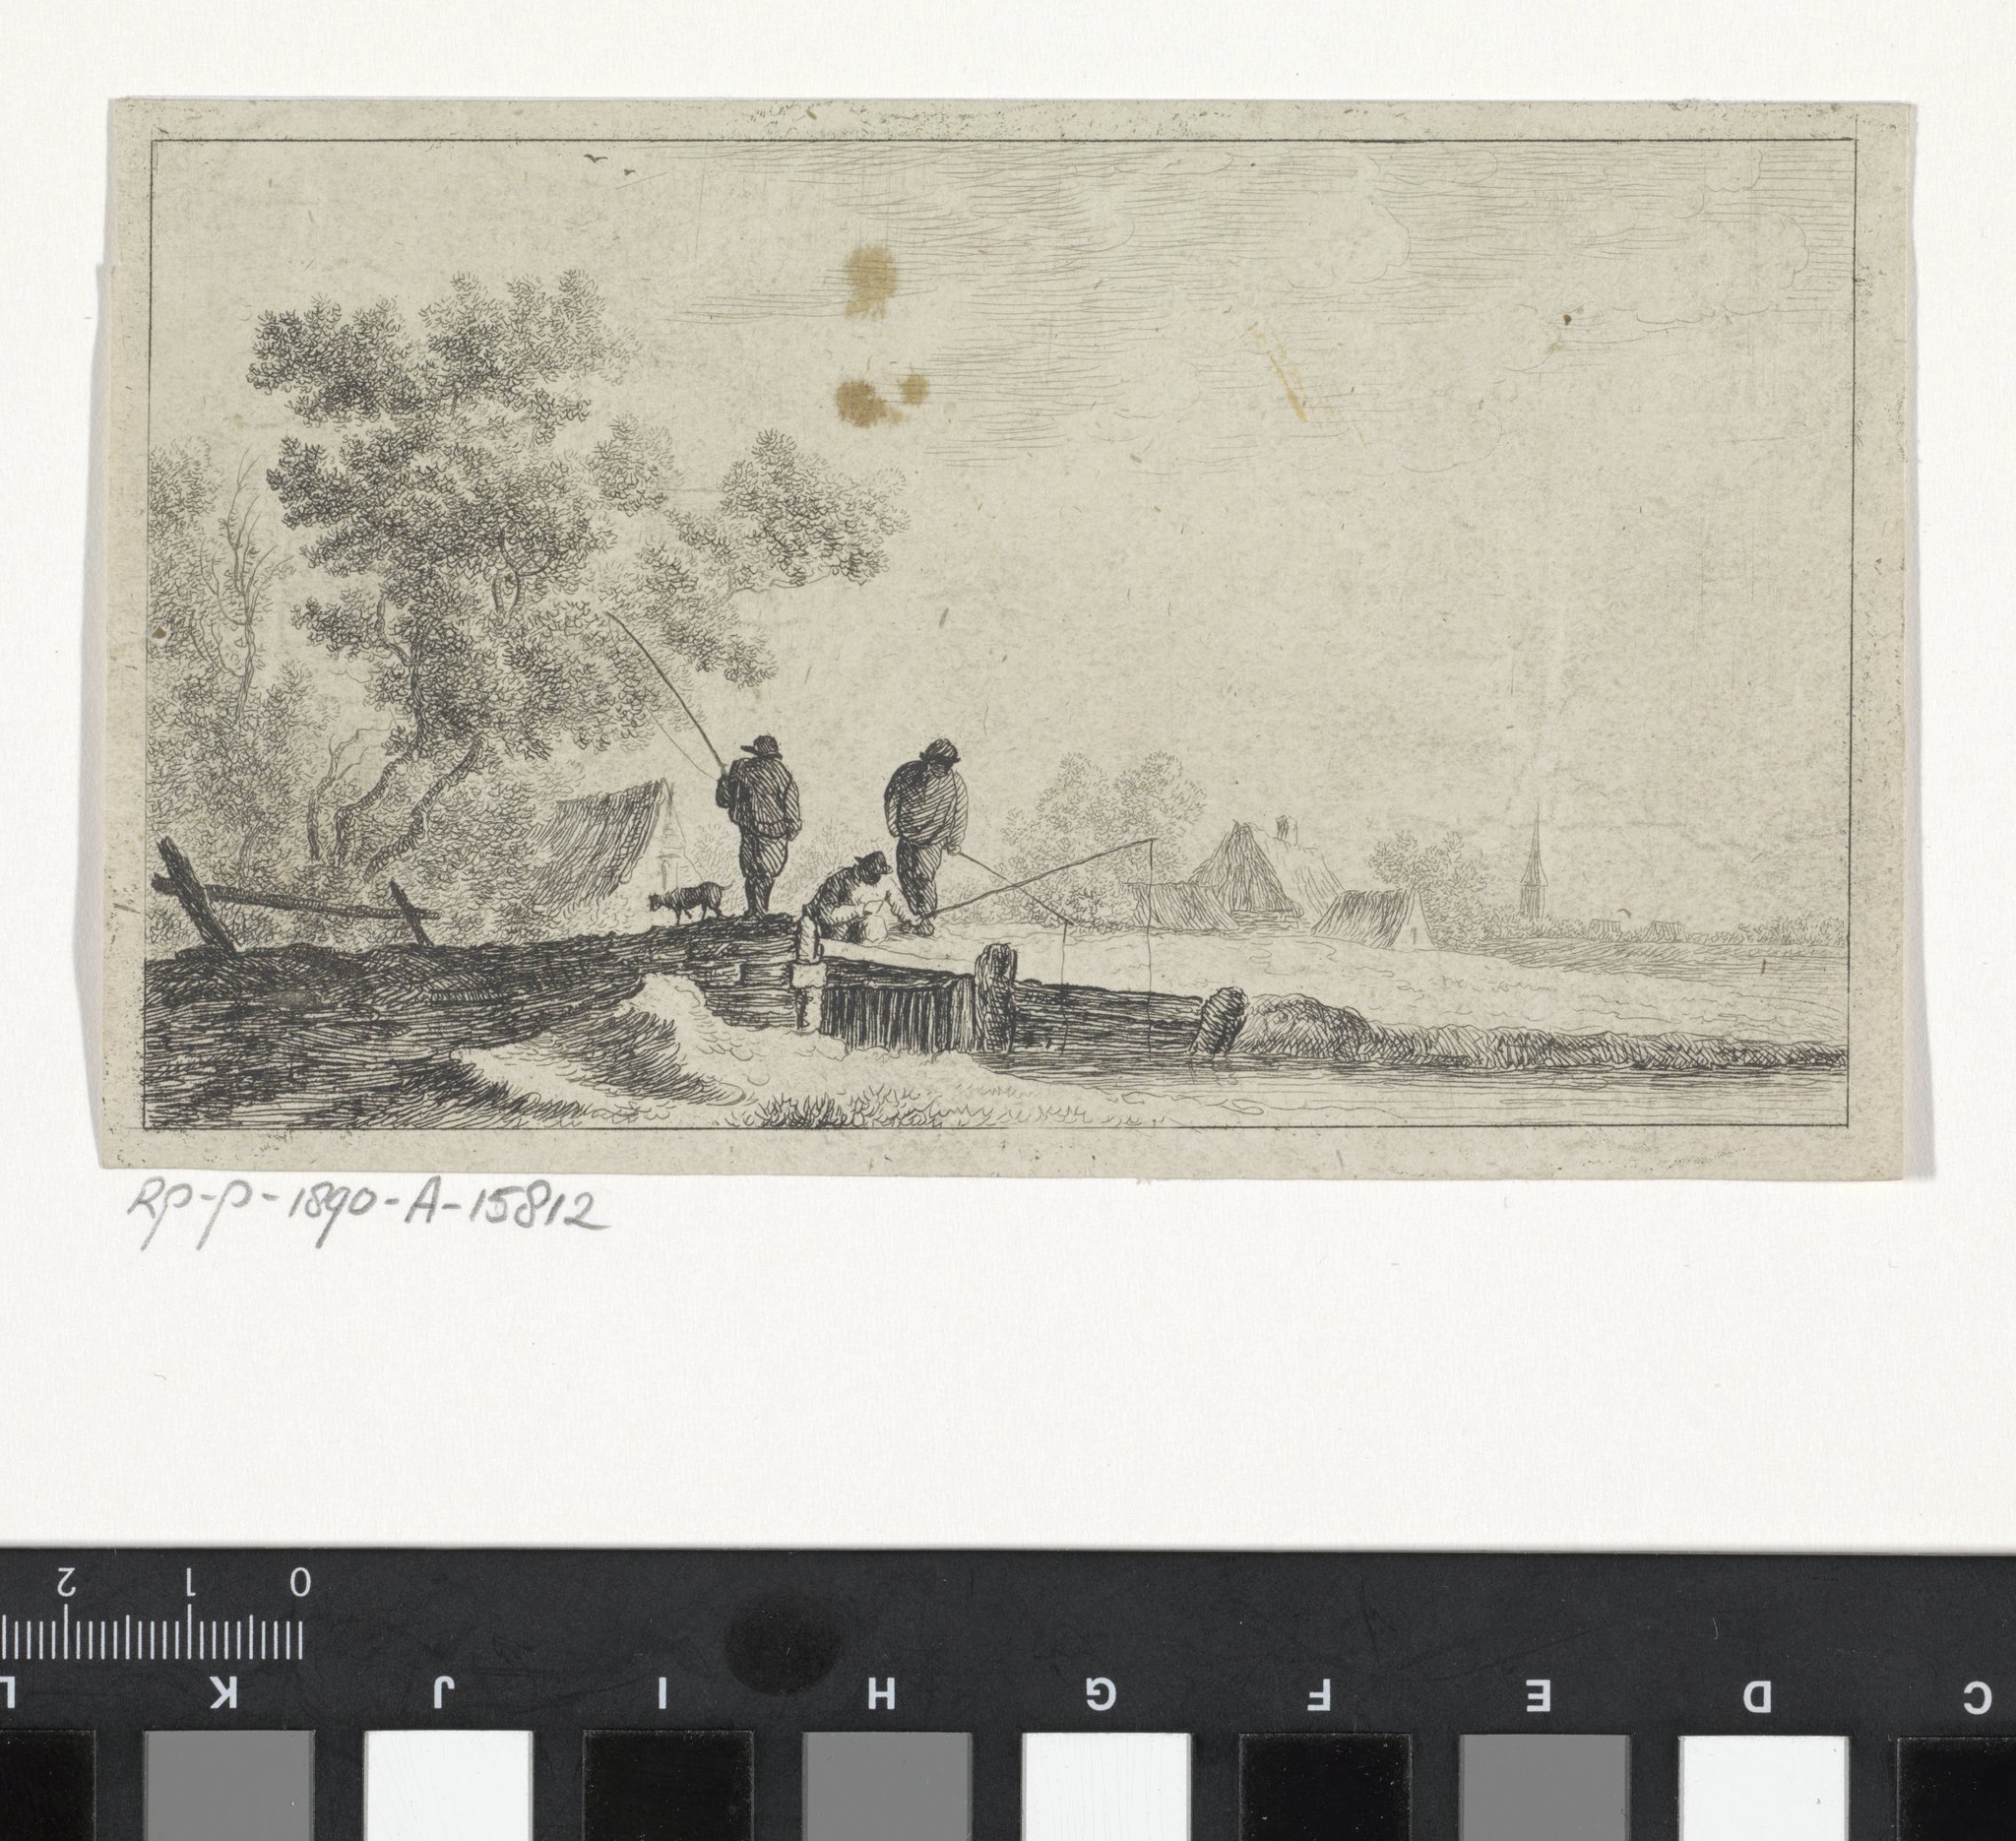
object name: print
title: Drie vissers op een brug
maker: Anonymous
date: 1630-1713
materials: paper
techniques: etching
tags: city-view, and landscape with man-made constructions, landscapes with waters, waterscapes, seascapes (in the temperate zone), bridge, fisherman, dog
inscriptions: collector's mark: Lugt 2228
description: Op een bruggetje over een rivier zijn drie vissers te zien. Ze worden vergezeld door een hond. Achter hen staan enkele huizen en in de verte is een kerk weergegeven.